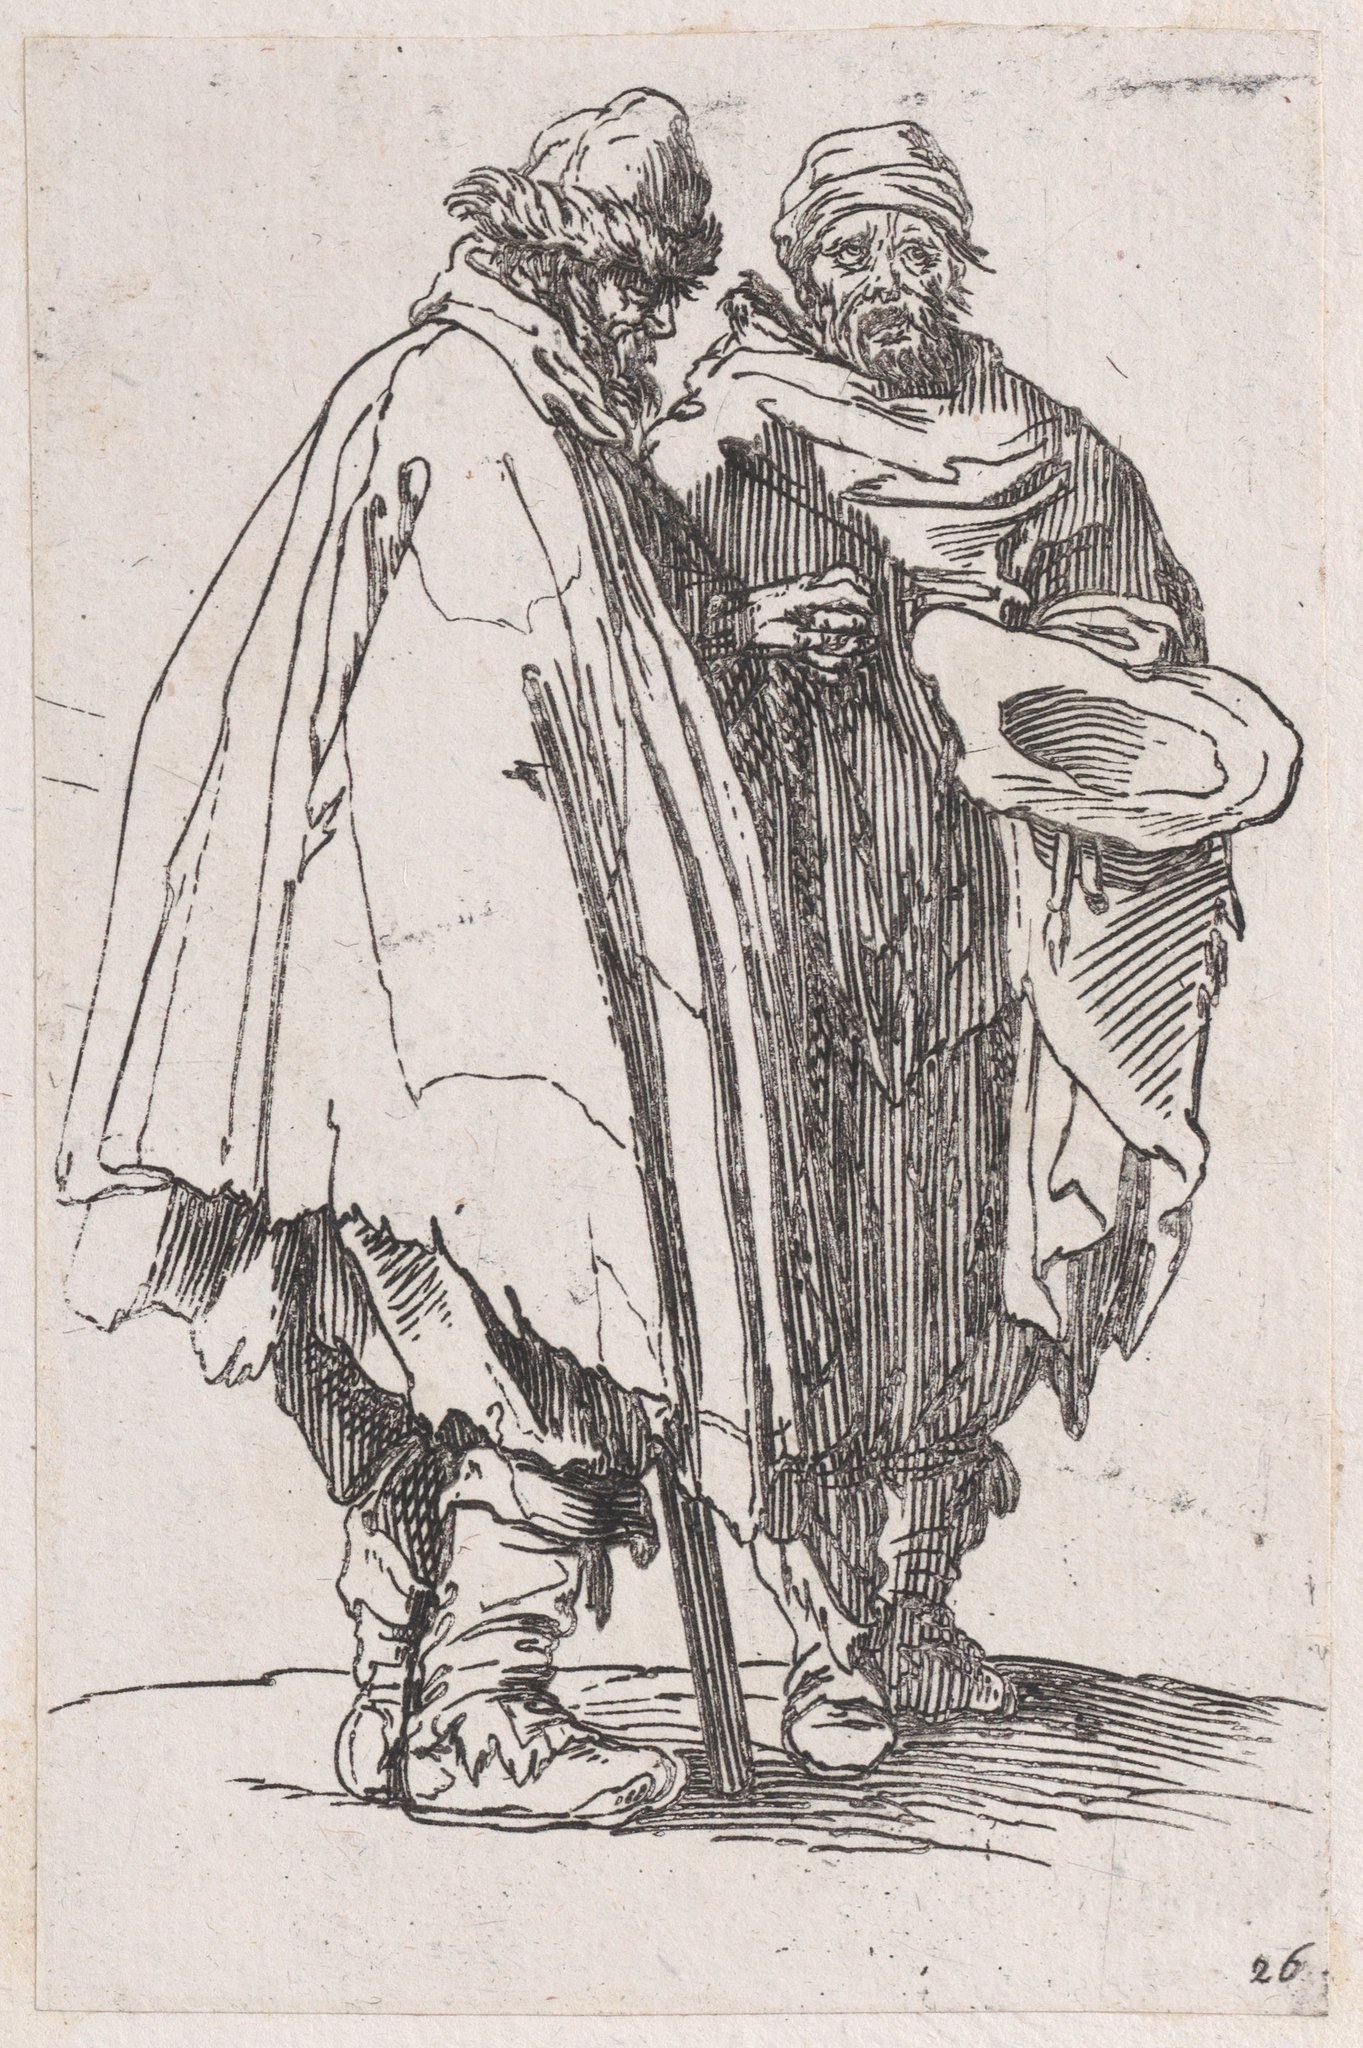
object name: print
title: Reverse Copy of L'Aveugle et son Compagnon (The Blind Man and his Companion), from Les Gueux suite appelée aussi Les Mendiants, Les Baroni, ou Les Barons (The Beggars, also called the Barons)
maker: Anonymous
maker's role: artist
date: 1601-1700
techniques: etching